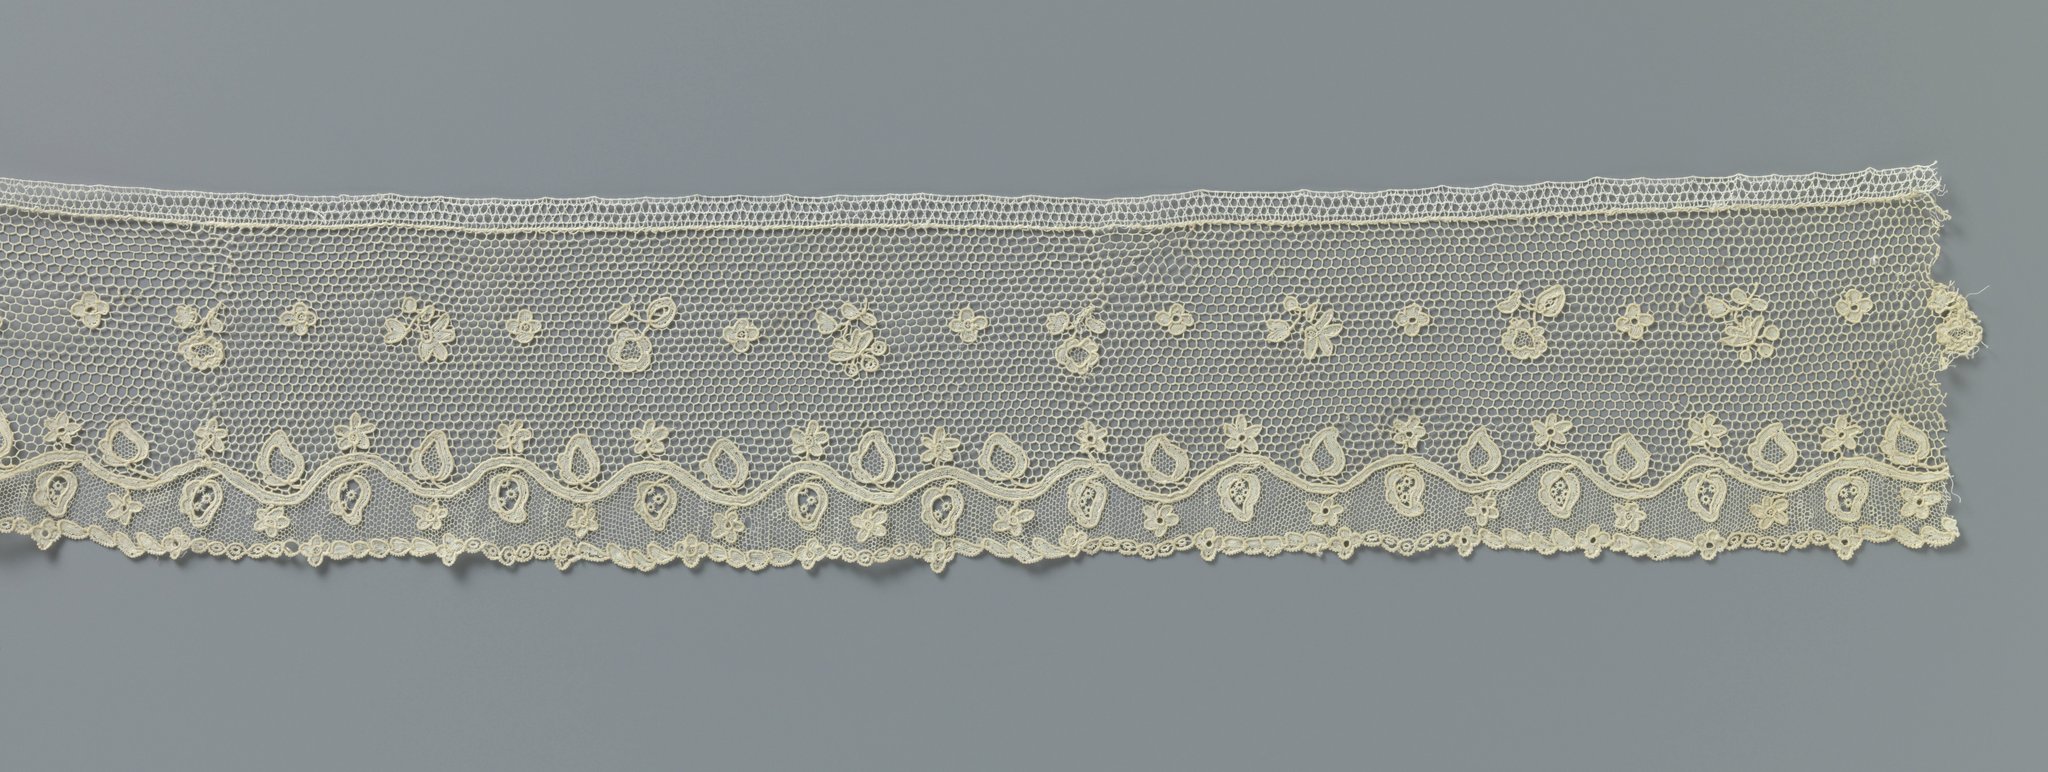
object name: strip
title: Strook gemengde kant met hartvormige blaadjes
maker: Anonymous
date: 1790-1799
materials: linen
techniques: lace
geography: france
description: Strook naturelkleurige gemengde kant, met op een machinaal vervaardigde tulegrond een versiering van naaldkant zoals in Argentan-kant. Het maliënfond van het veld is met bloempjes en kleine rozetjes bezaaid; een fijn mazenfond vult het randje. Als scheiding dient een golvende tak met hartvormige blaadjes en bloempjes. De buitenrand is bijna recht en samengesteld uit rozetjes, blaadjes en een keten van cirkeltjes.